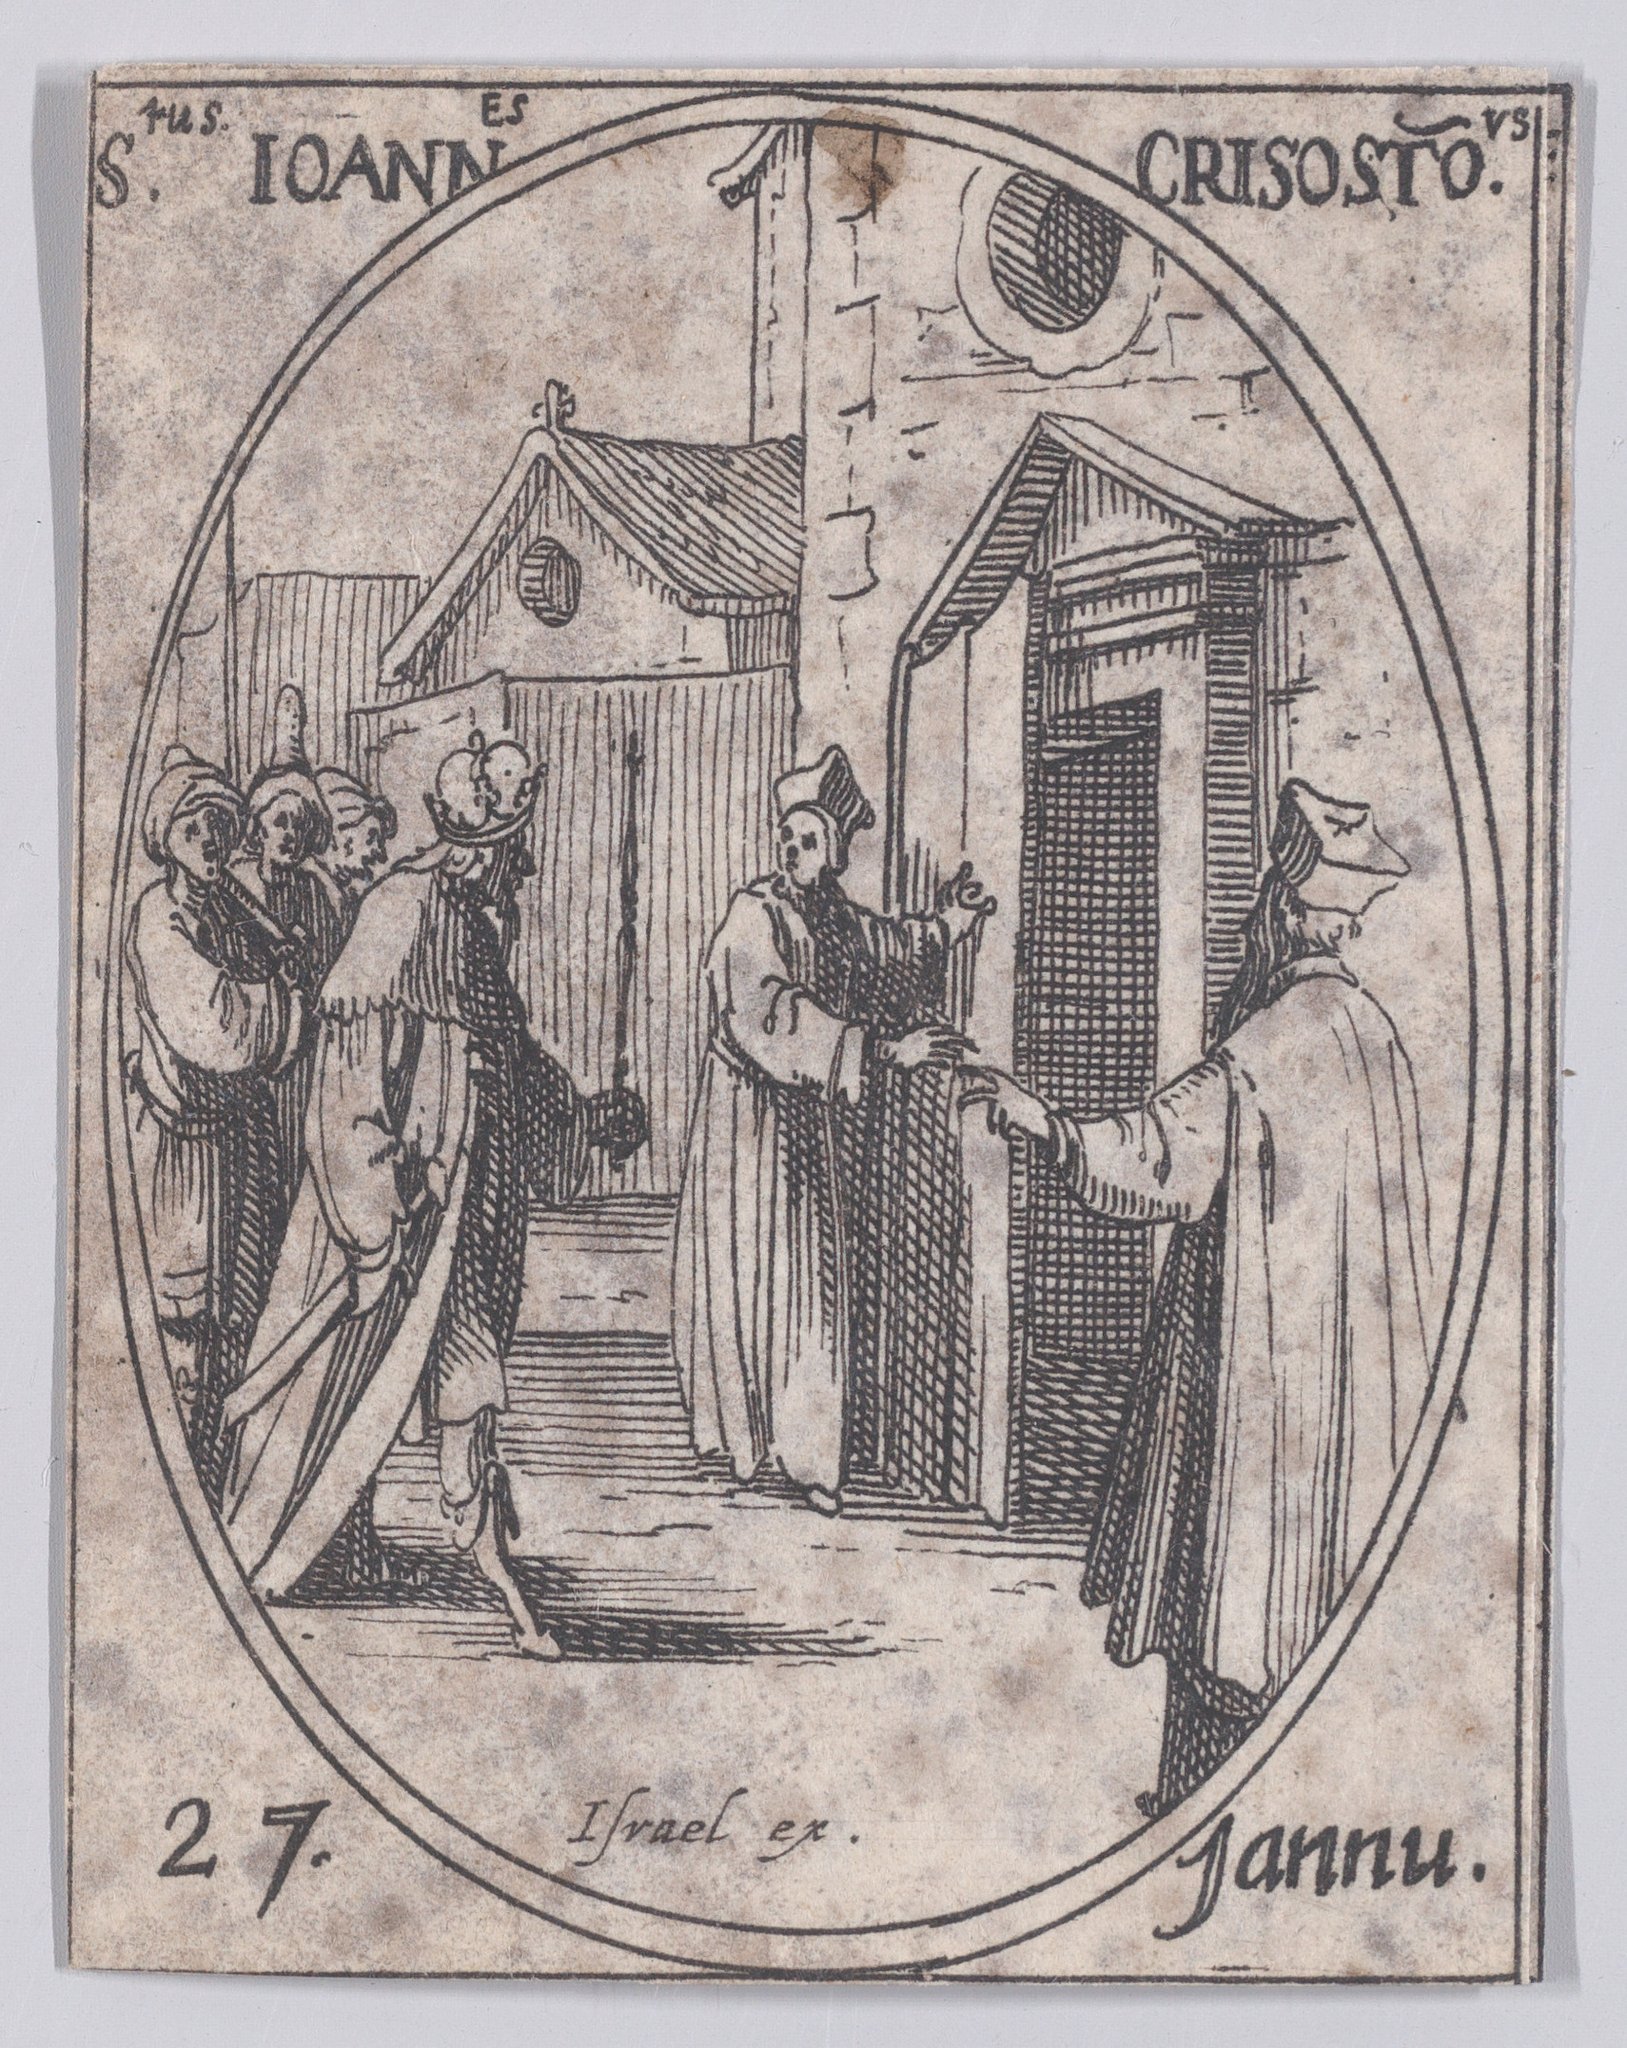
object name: print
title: S. Jean Chrysostome (St. John Chrisostome), January 27th, from "Les Images De Tous Les Saincts et Saintes de L'Année" (Images of All of the Saints and Feast Days of the Year)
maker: jacques callot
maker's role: artist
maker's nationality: french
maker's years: 1592-1635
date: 1636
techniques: etching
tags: men,saints